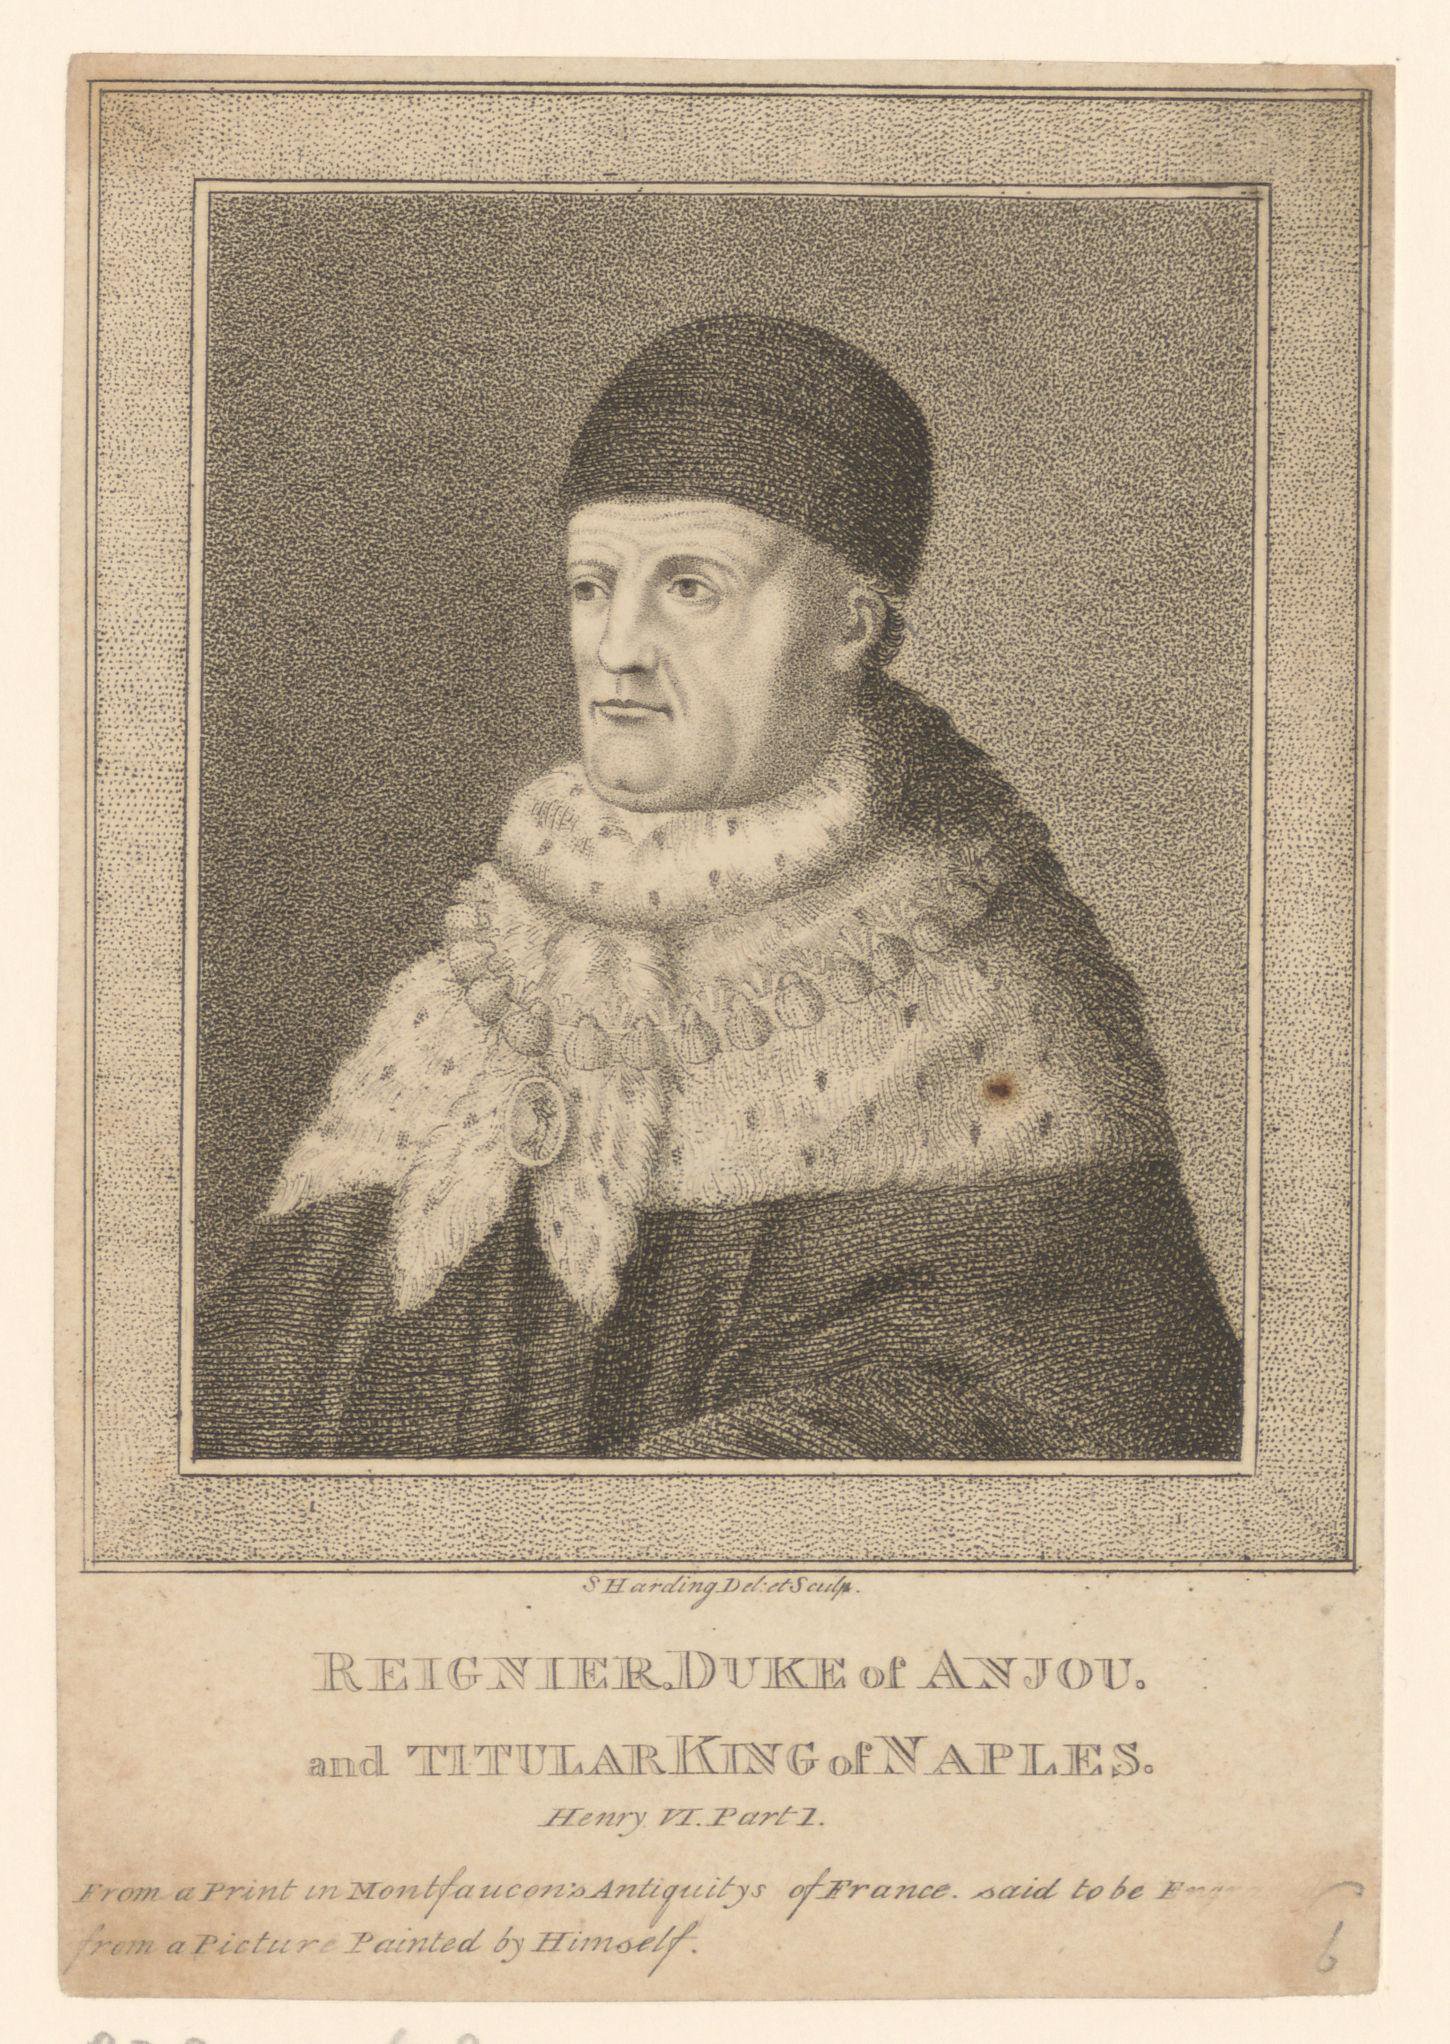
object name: print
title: Shakspeare Illustrated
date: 1793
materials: paper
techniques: etching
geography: london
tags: rené i van anjou, historical persons, ruler, sovereign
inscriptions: collector's mark: Lugt 2228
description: Prent uit: Shak[e]speare Illustrated (...). Londen: Sylvester en Edward Harding, 1793.